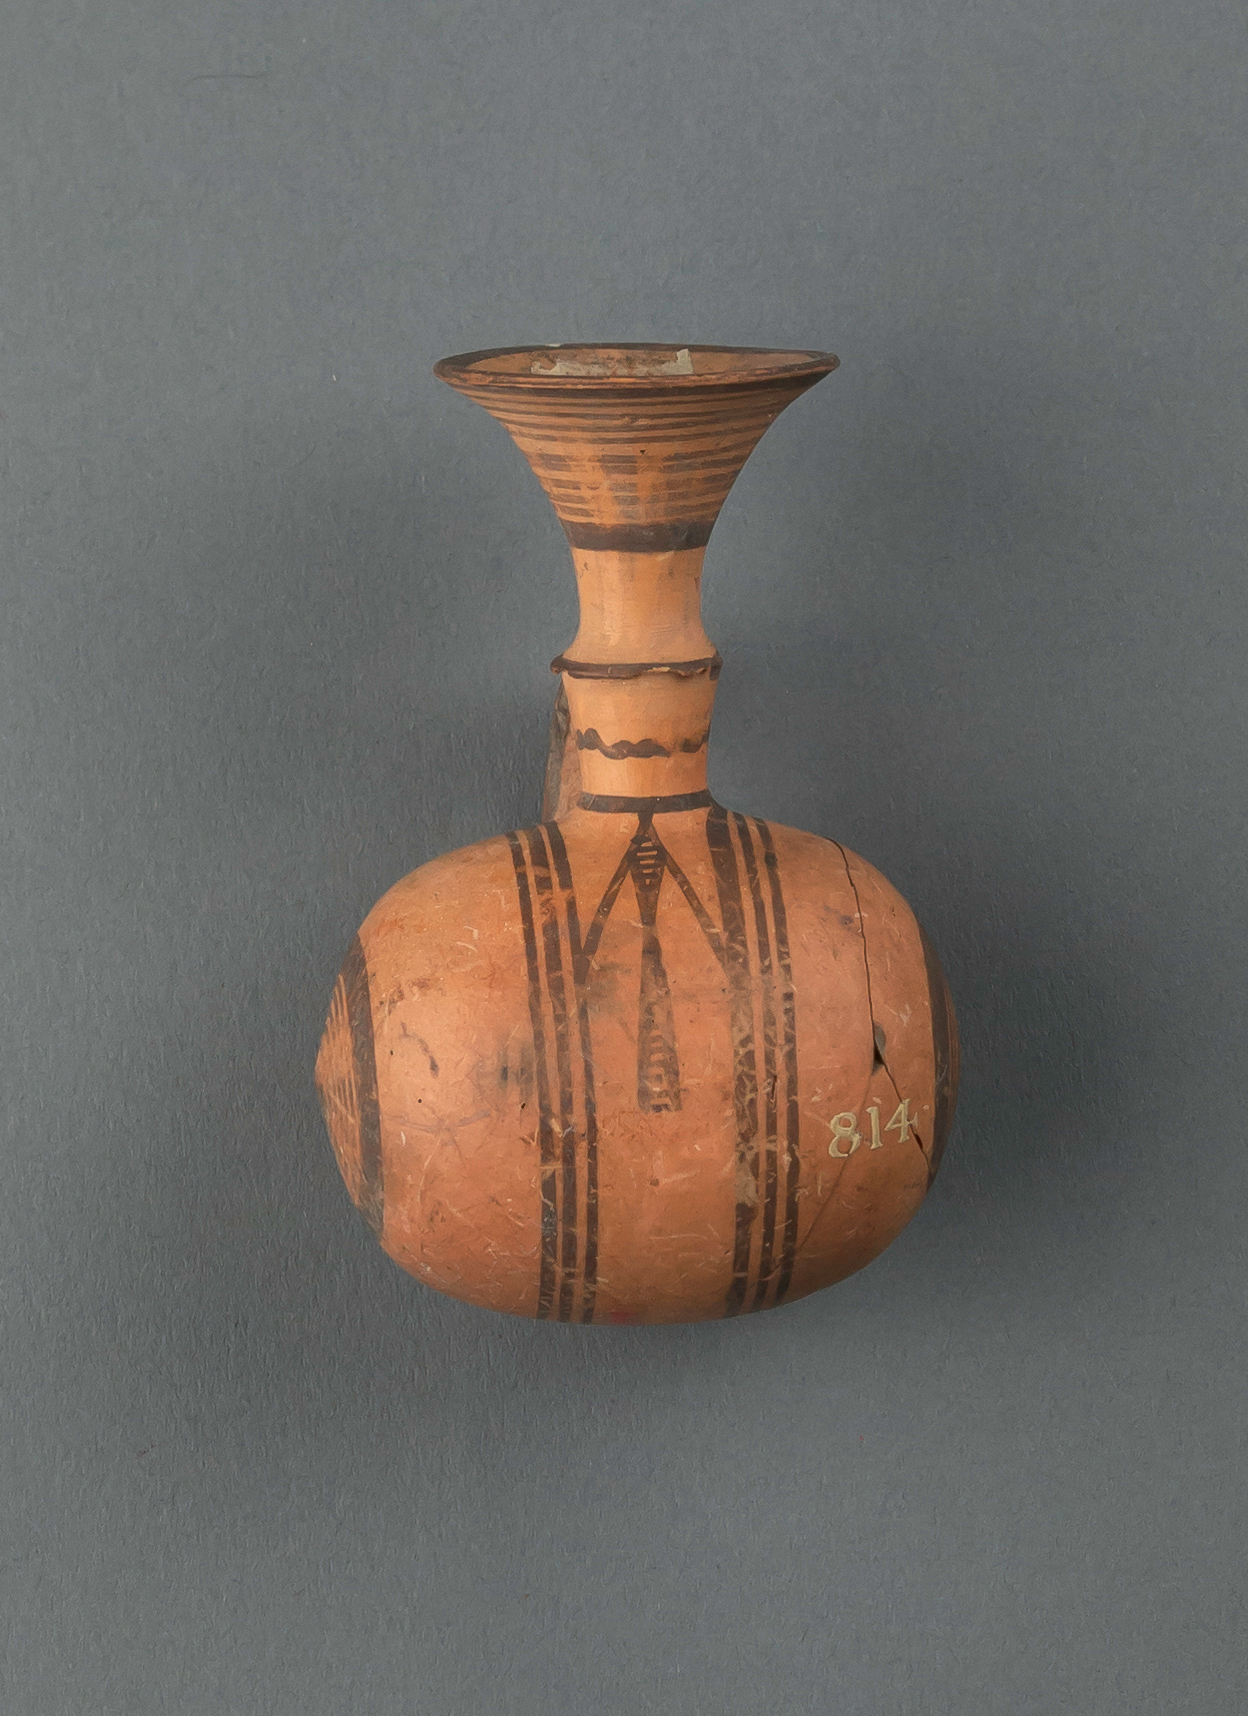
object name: jug, barrel shaped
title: Jug, barrel-shaped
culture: cypriot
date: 850-750 BCE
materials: terracotta